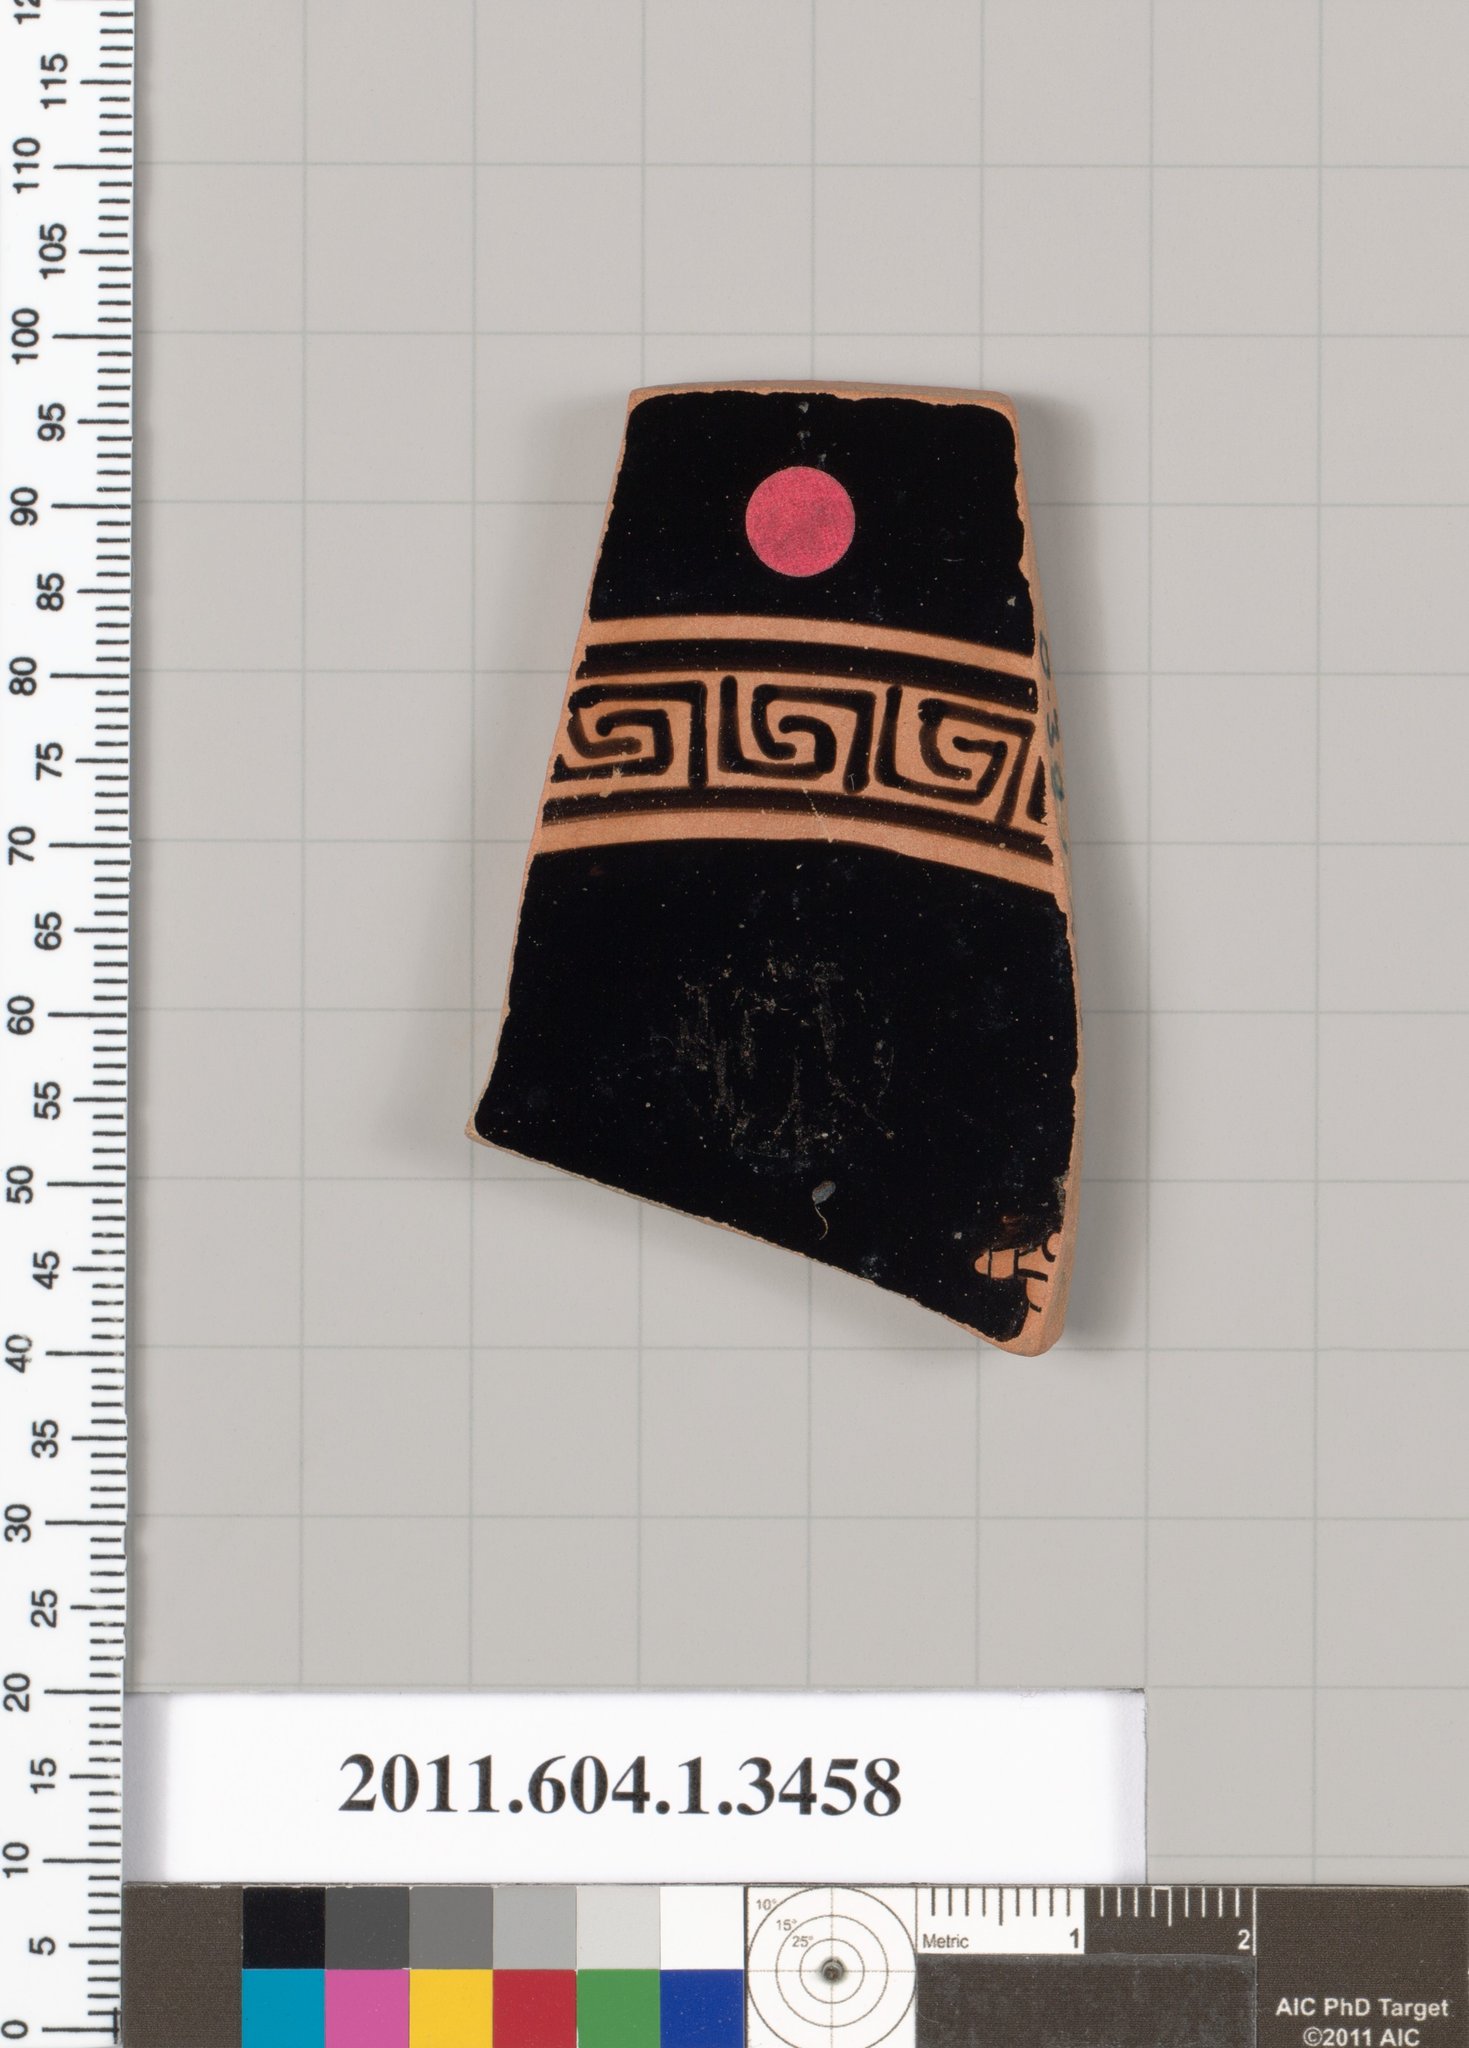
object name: kylix fragment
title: Terracotta fragment of a kylix (drinking cup)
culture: greek, attic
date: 490-470 BCE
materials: terracotta